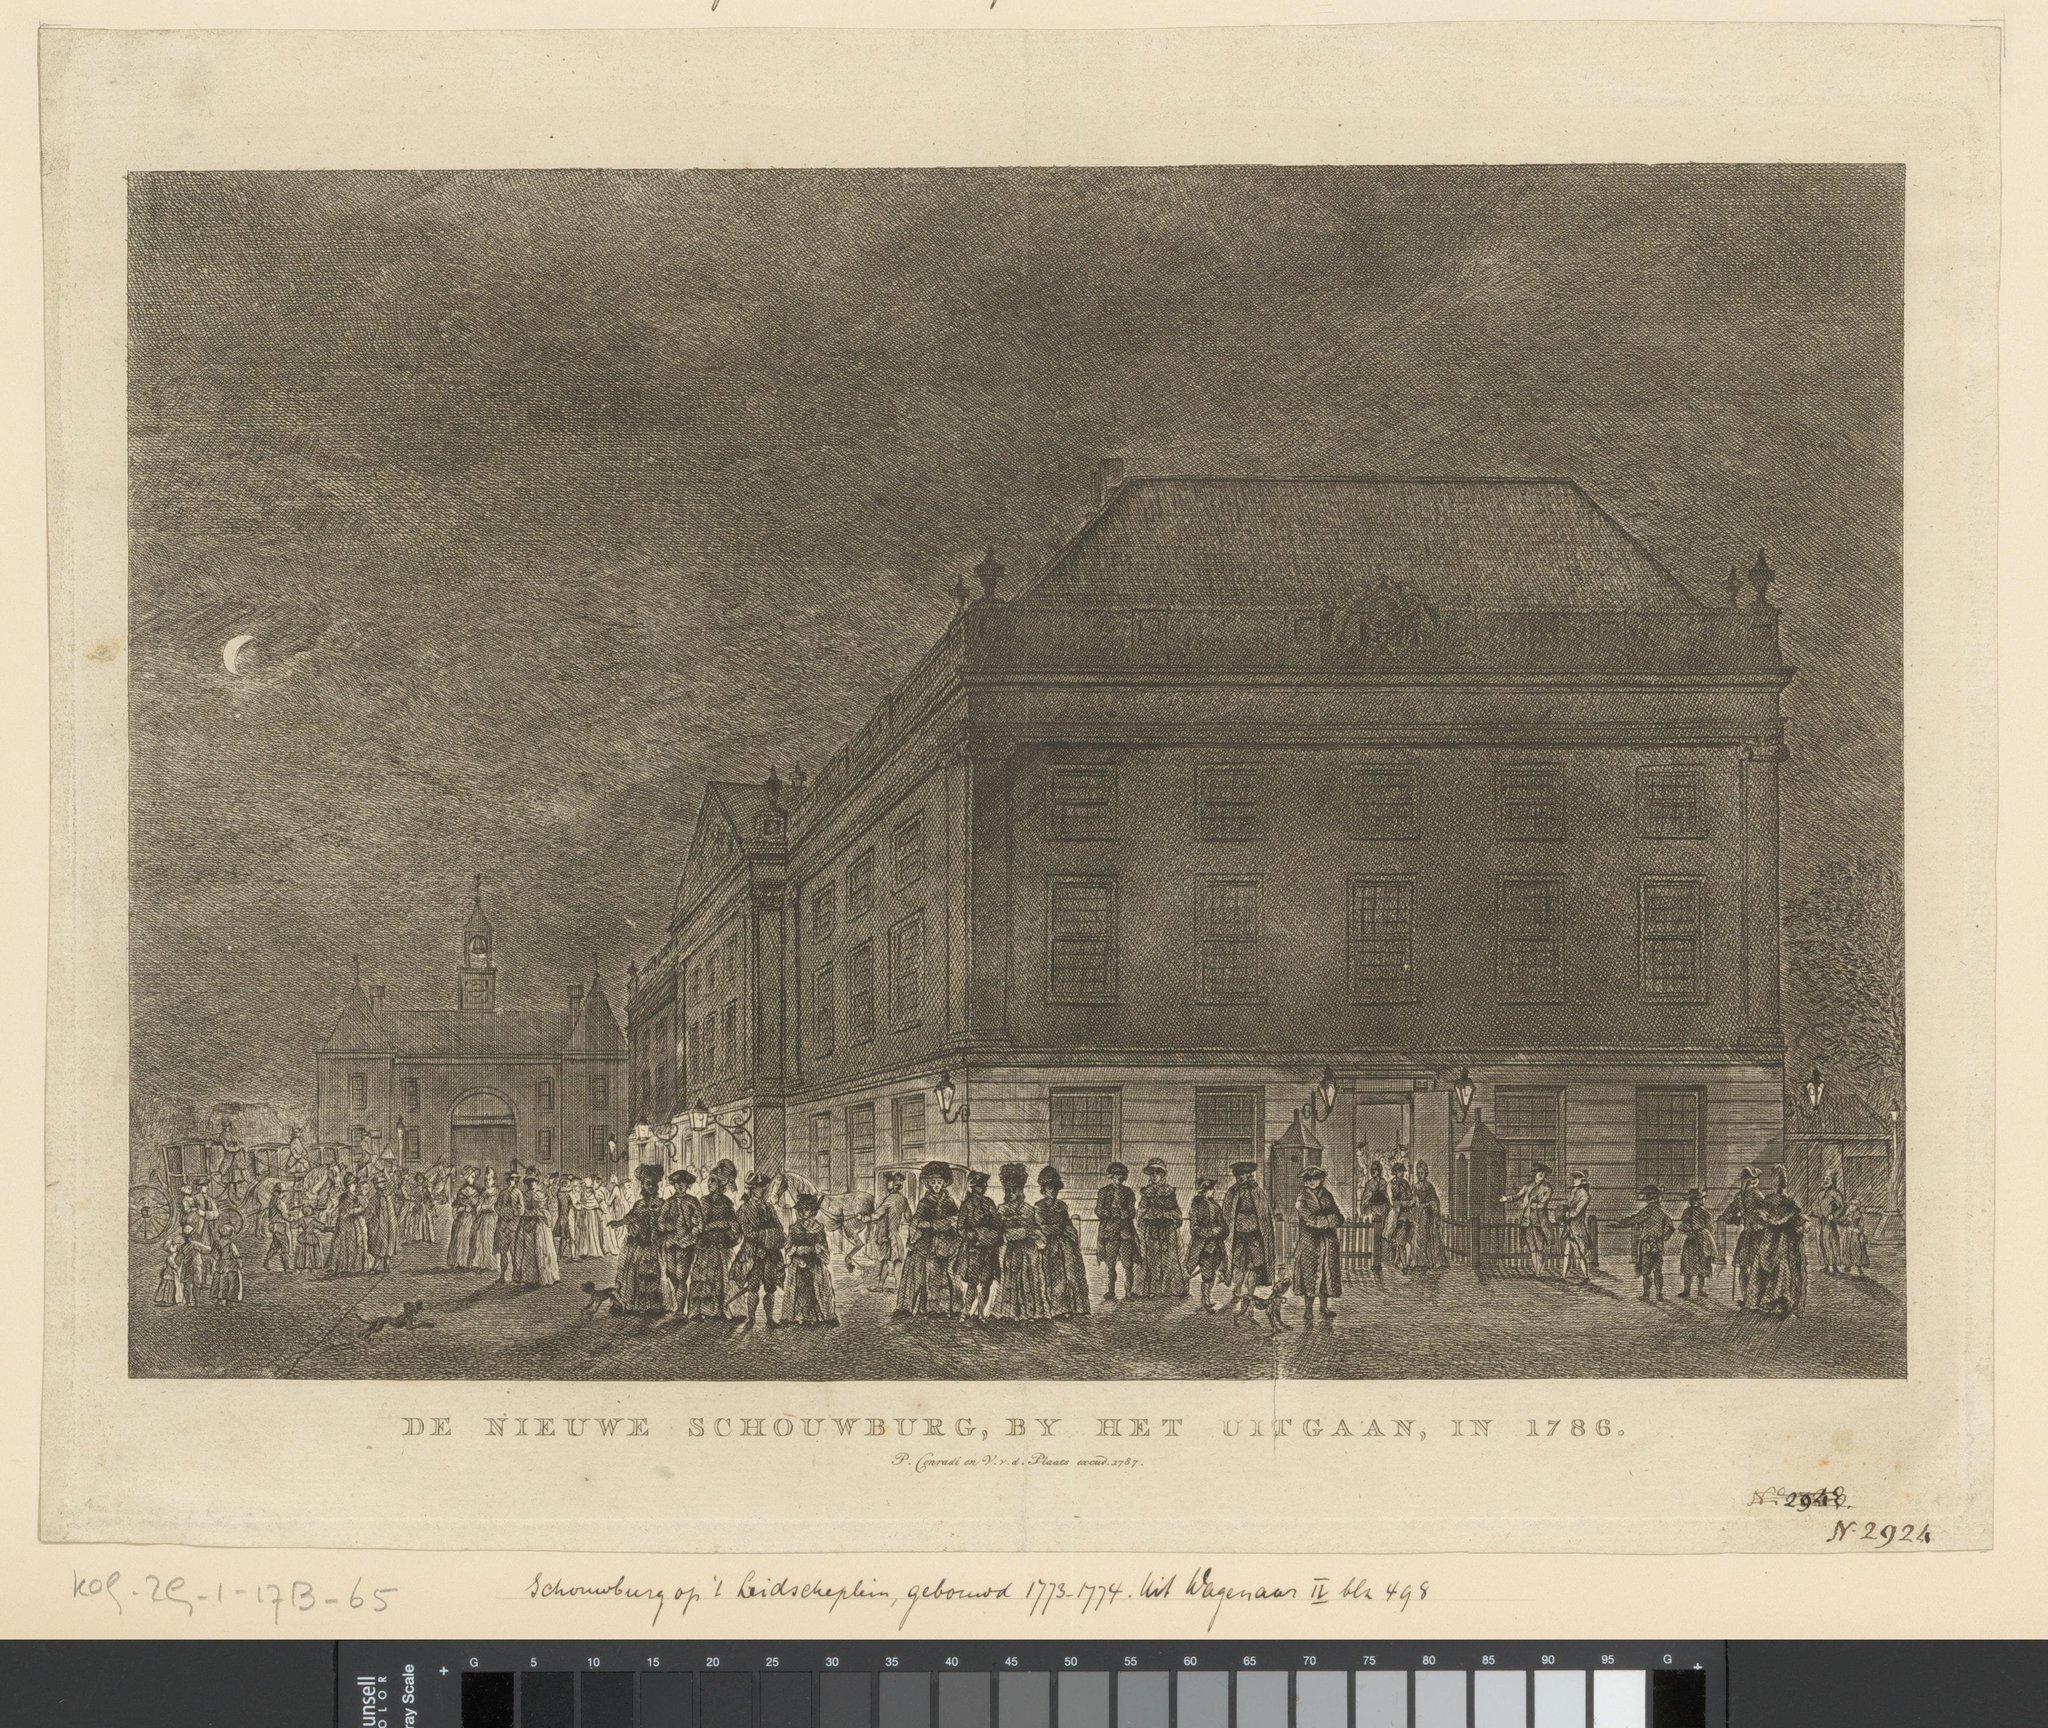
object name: print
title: Gezicht op de schouwburg aan het Leidseplein te Amsterdam bij avond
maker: hermanus schouten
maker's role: artist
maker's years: 1714-1786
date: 1787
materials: paper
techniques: engraving, etching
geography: amsterdam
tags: theatre (building), city-gate, square, place, circus, etc. (+ city(-scape) with figures, staffage)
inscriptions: stamp, collector's mark: Lugt 1641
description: Prent uit: Stijl, Simon. Amsterdam, in zyne geschiedenissen, voorregten, koophandel, gebouwen, kerkenstaat, schoolen, schutterye, gilden en regeeringe, beschreeven. Om te dienen ten vervolge op het werk van Jan Wagenaar (…). 10 dln. Amsterdam en Harlingen: Petrus Conradi en Folkert van der Plaats, 1788-1801. Eerder is deze prent ook uitgegeven in diverse edities van de Atlas Fouquet, en later nog door Evert Maaskamp (1805).